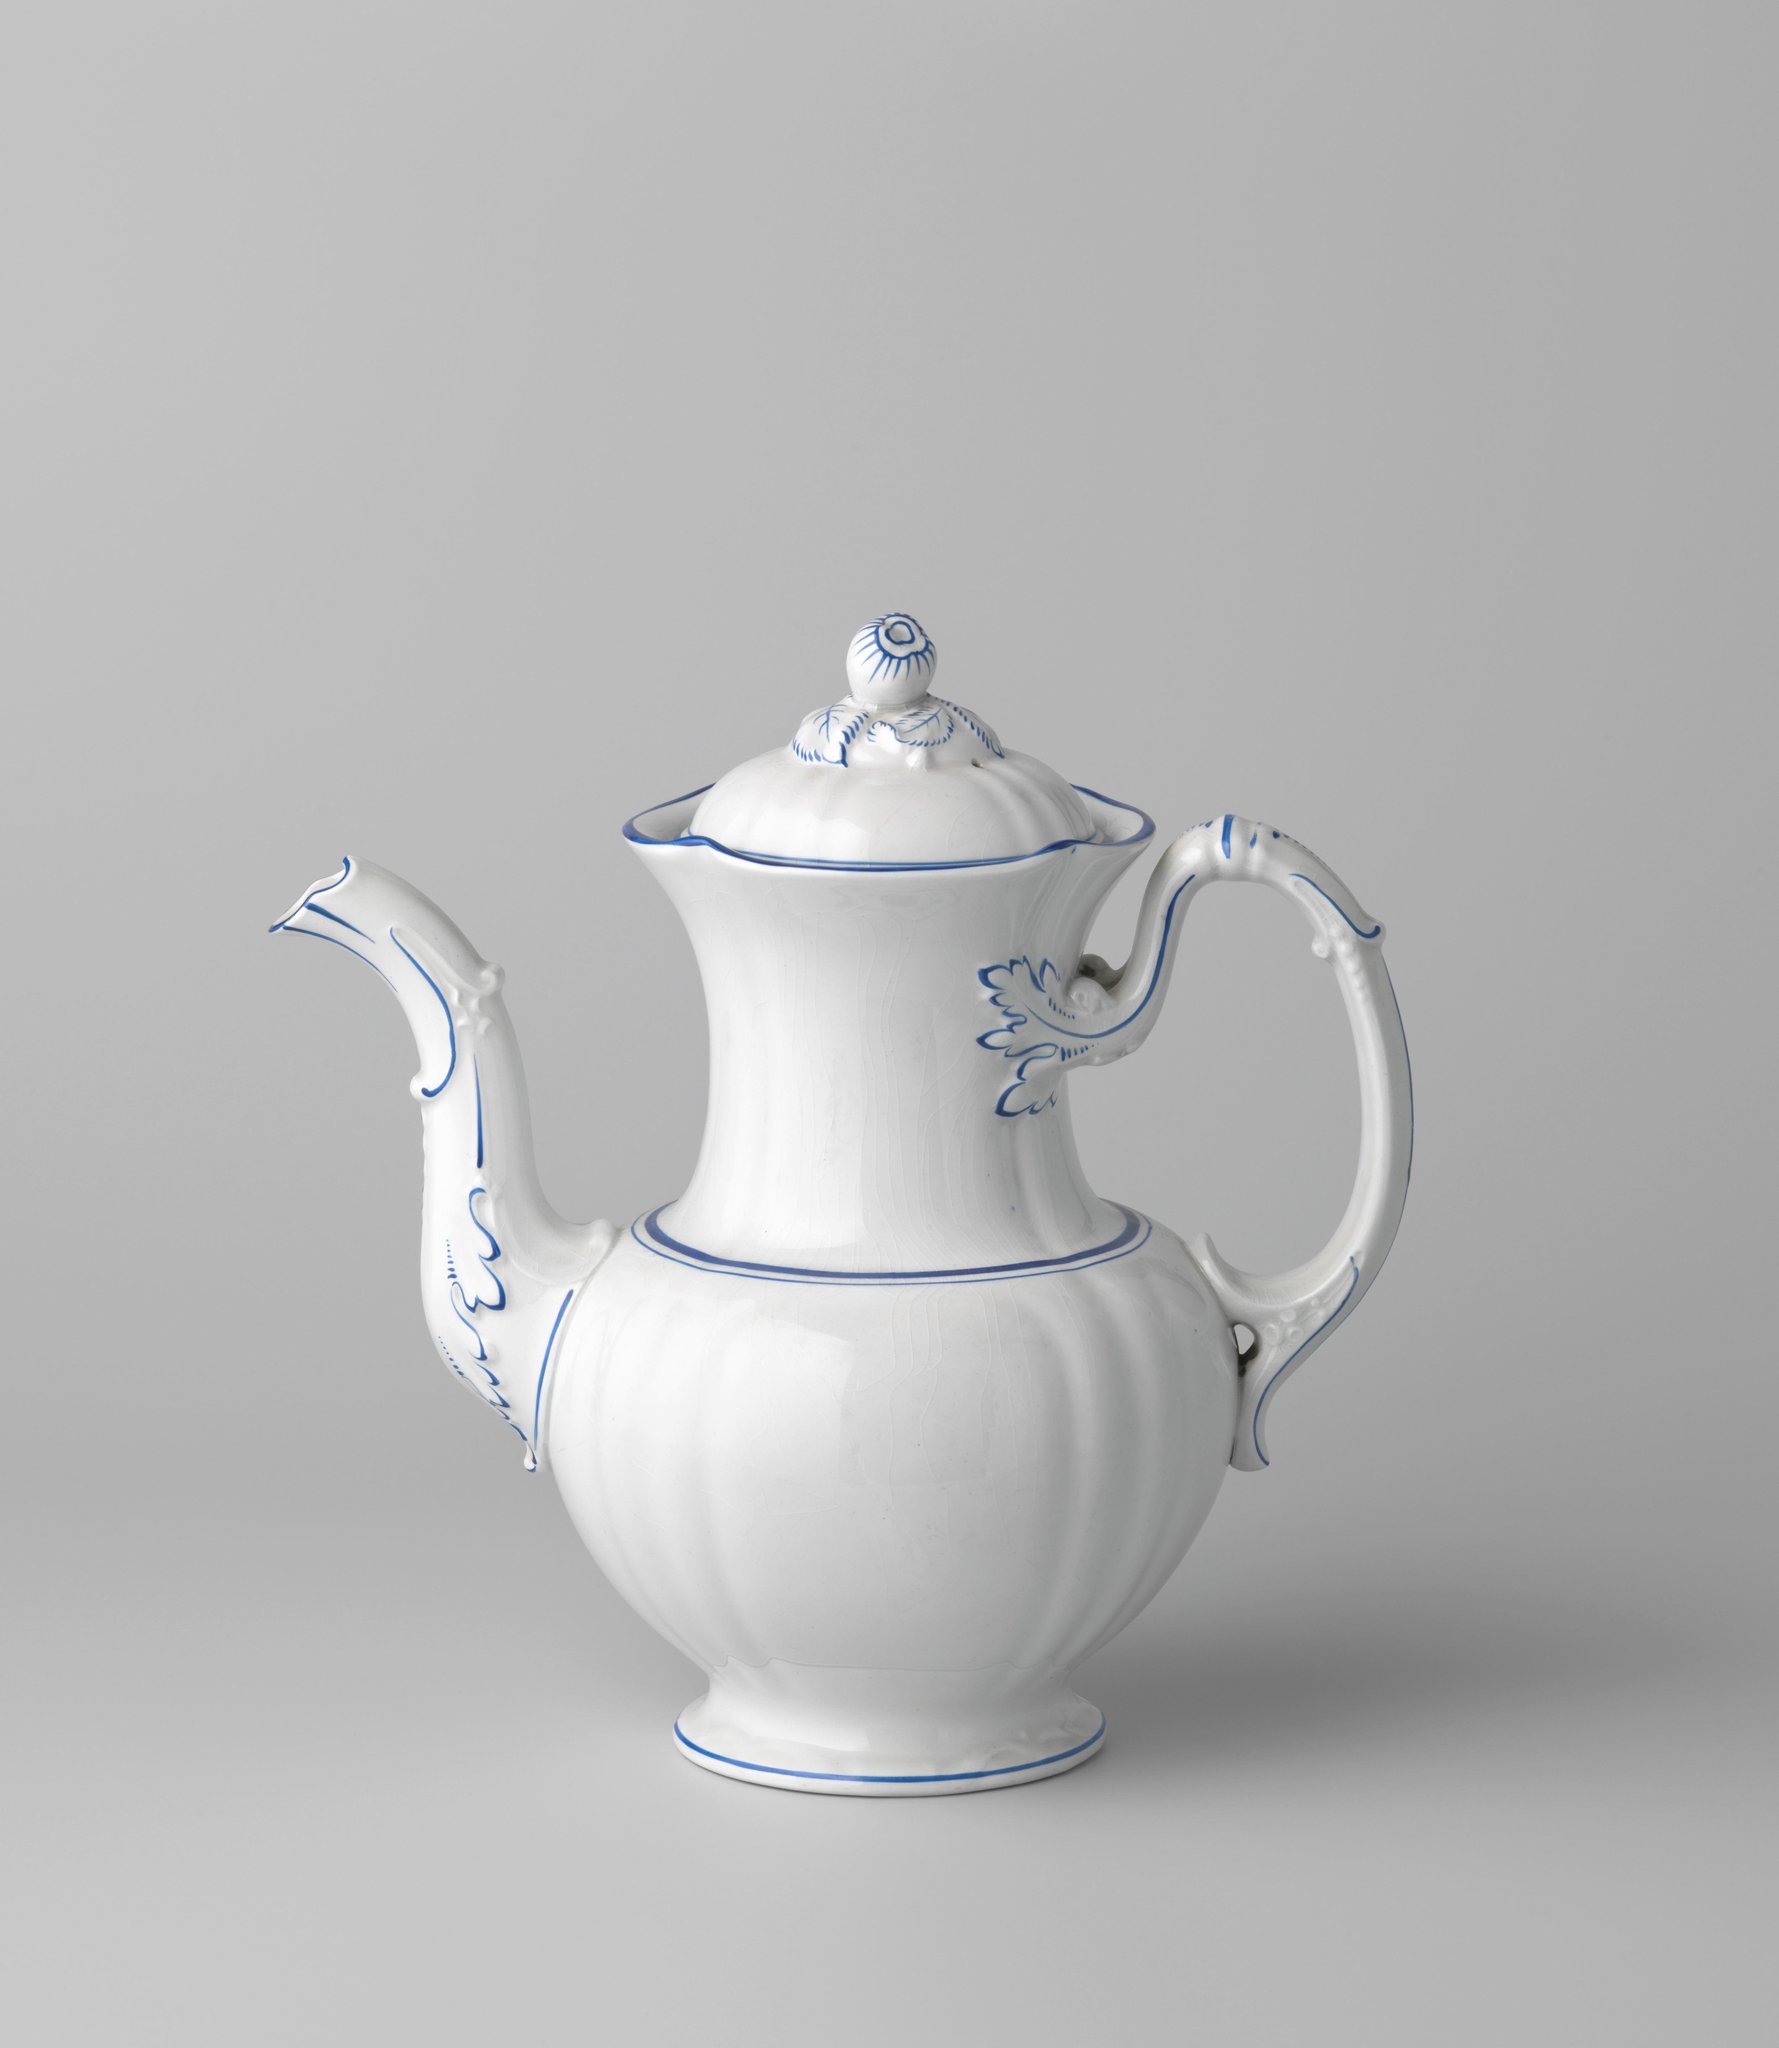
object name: coffee pot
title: Koffiepot met deksel, wit, met blauwe biezen en peervormige dekselknop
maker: petrus regout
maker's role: plateelbakker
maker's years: 1801-1879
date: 1860-1890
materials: creamware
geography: maastricht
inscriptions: check stamp: ‘P. REGOUT // MAASTRICHT // 16 X’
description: Koffiepot met deksel van aardewerk, behorend bij een koffie- en theeservies, wit, met blauwe biezen en peervormige dekselknop.